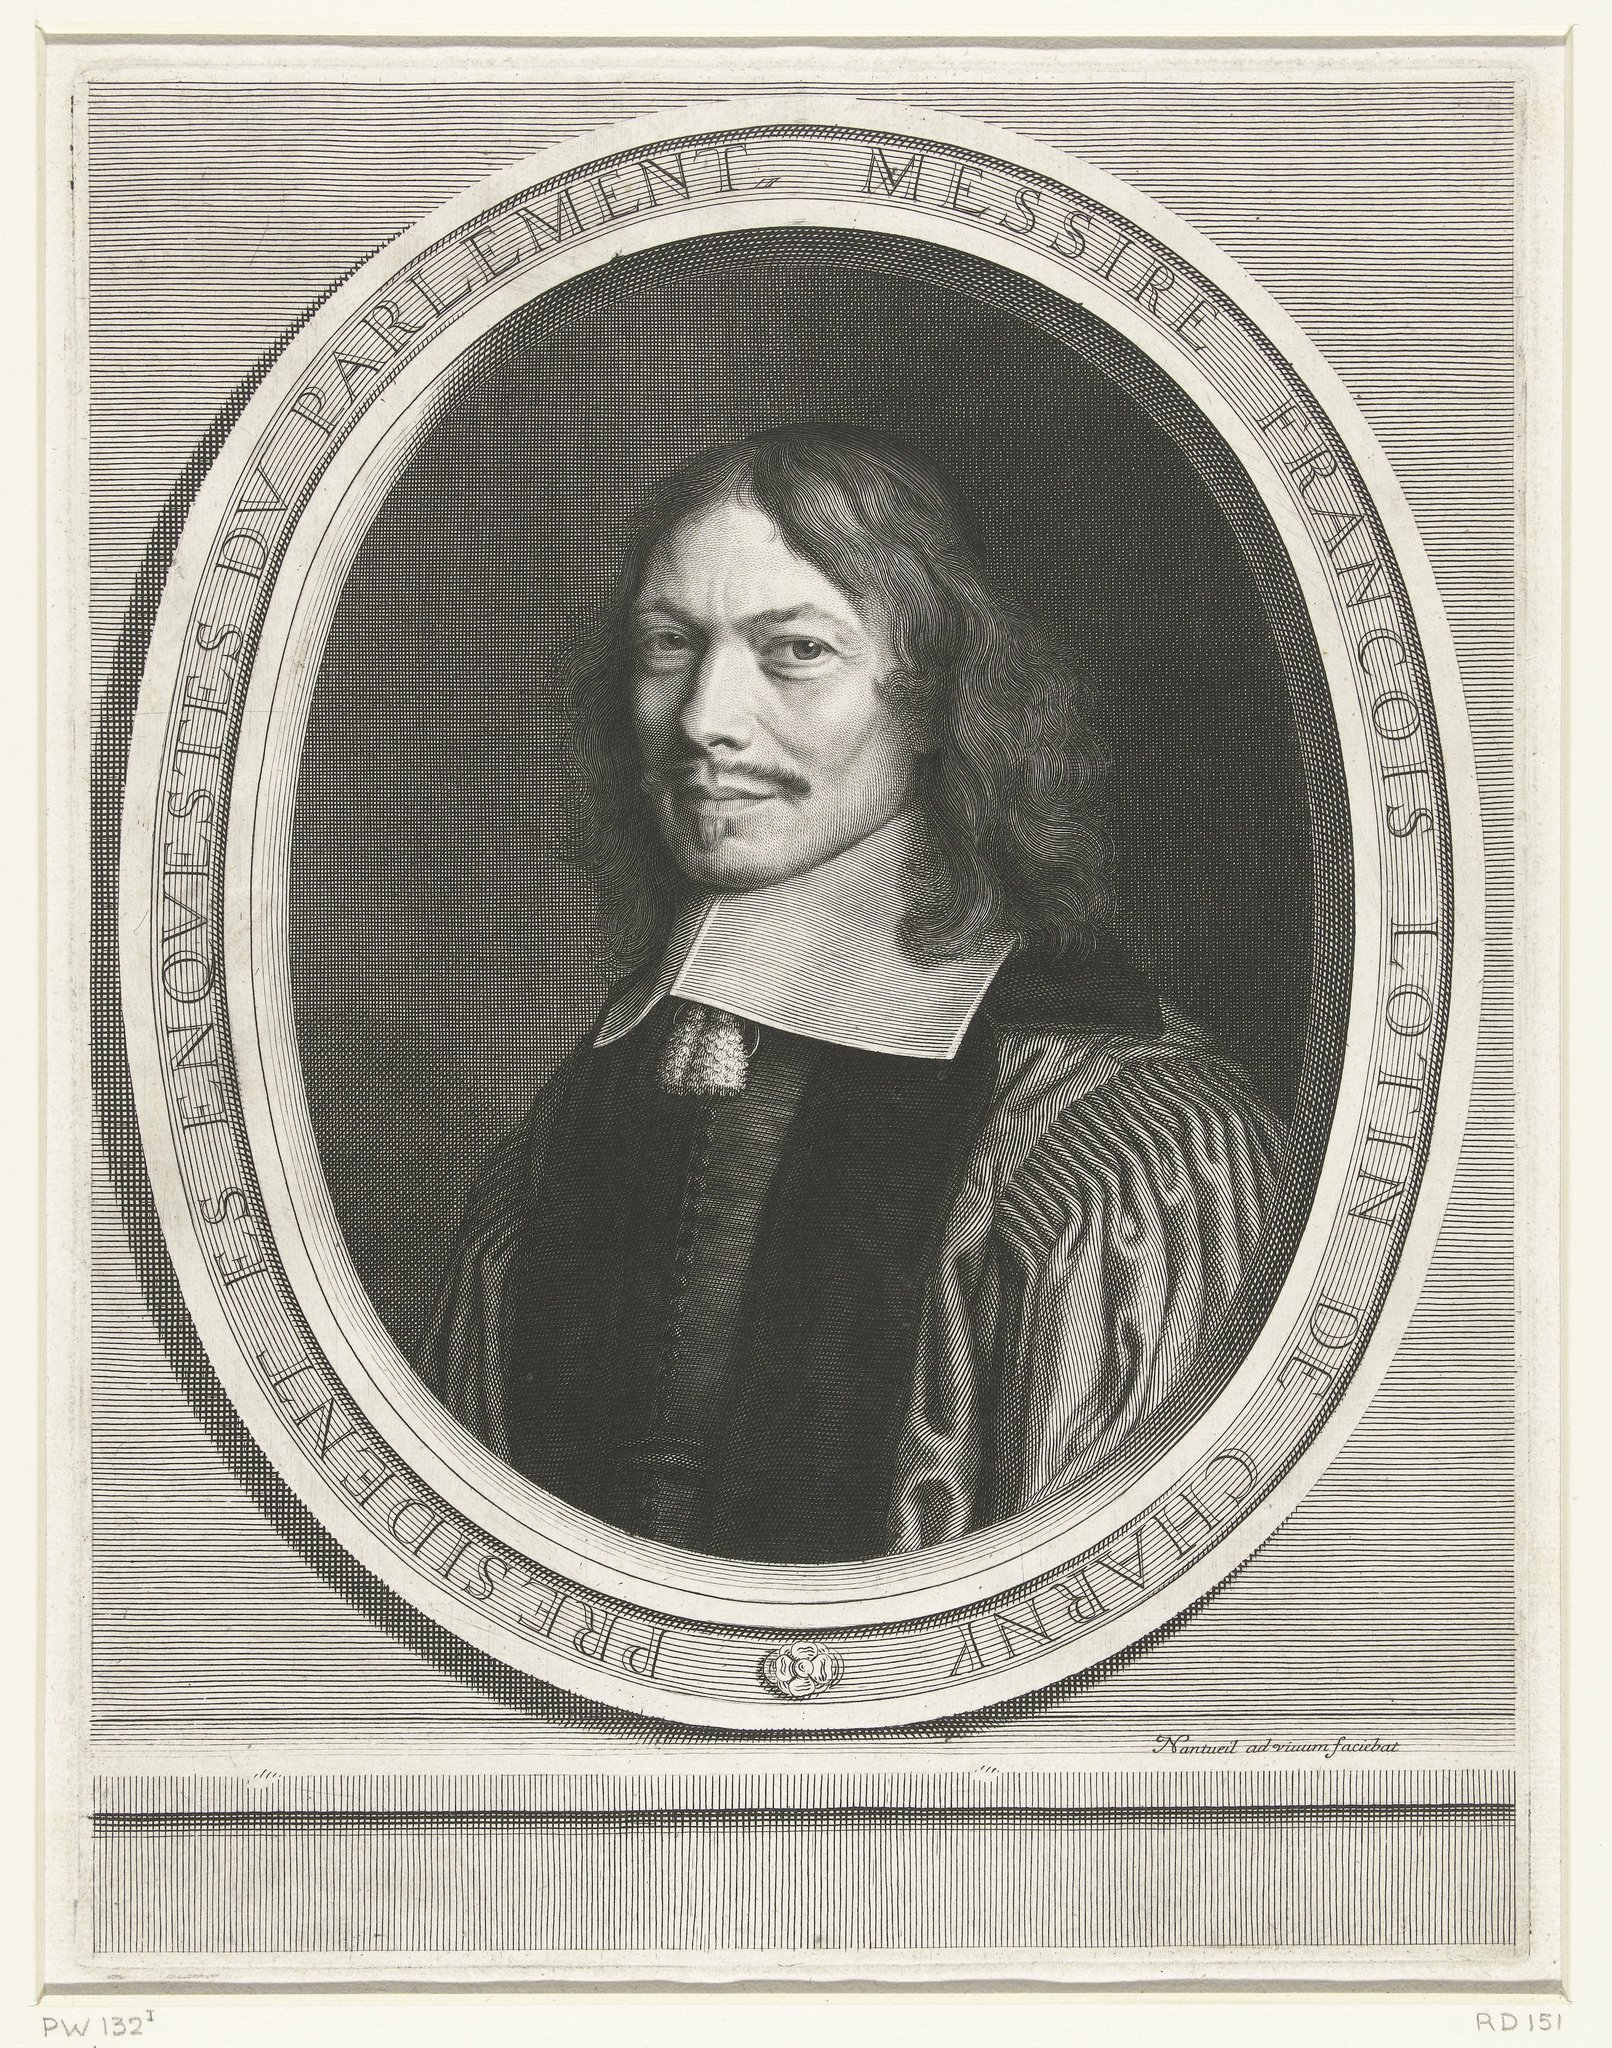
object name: print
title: Portret van François Lotin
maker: robert nanteuil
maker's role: print maker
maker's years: 1623-1678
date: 1657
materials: paper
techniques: engraving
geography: france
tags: raadsheer, françois lotin de charny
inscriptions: collector's mark: Lugt 2228, collector's mark: Lugt 2760, collector's mark: Lugt 548, collector's mark: Lugt 533b, collector's mark: Lugt 654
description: Portret van François Lotin, heer van Charny, in een ovale omlijsting met tekst.